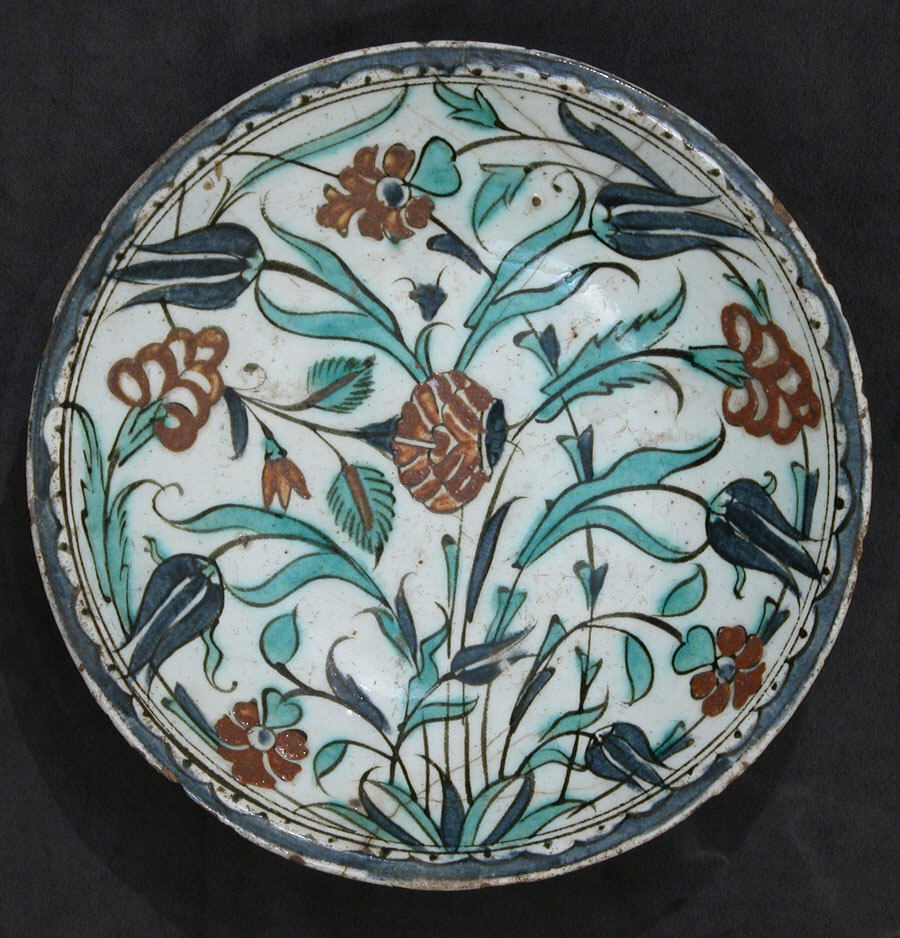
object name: dish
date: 1601-1700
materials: stonepaste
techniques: painting, underglaze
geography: turkey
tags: flowers,leaves